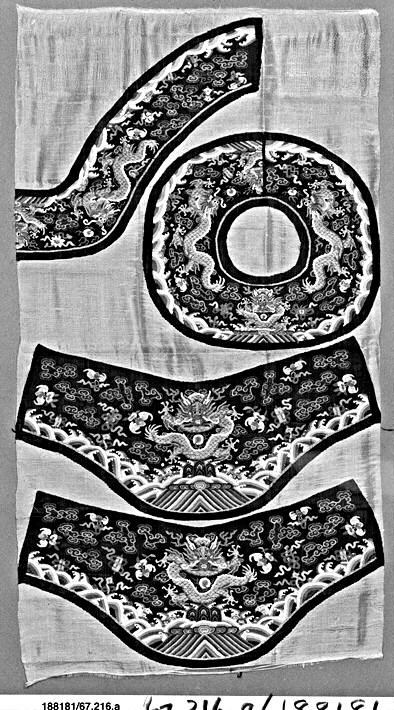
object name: neckband, cuff, for imperial woman's dragon robe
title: Neckband, Cuffs, for Imperial Woman's Dragon Robe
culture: chinese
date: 1801-1900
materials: metal thread, paint, silk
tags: dragons